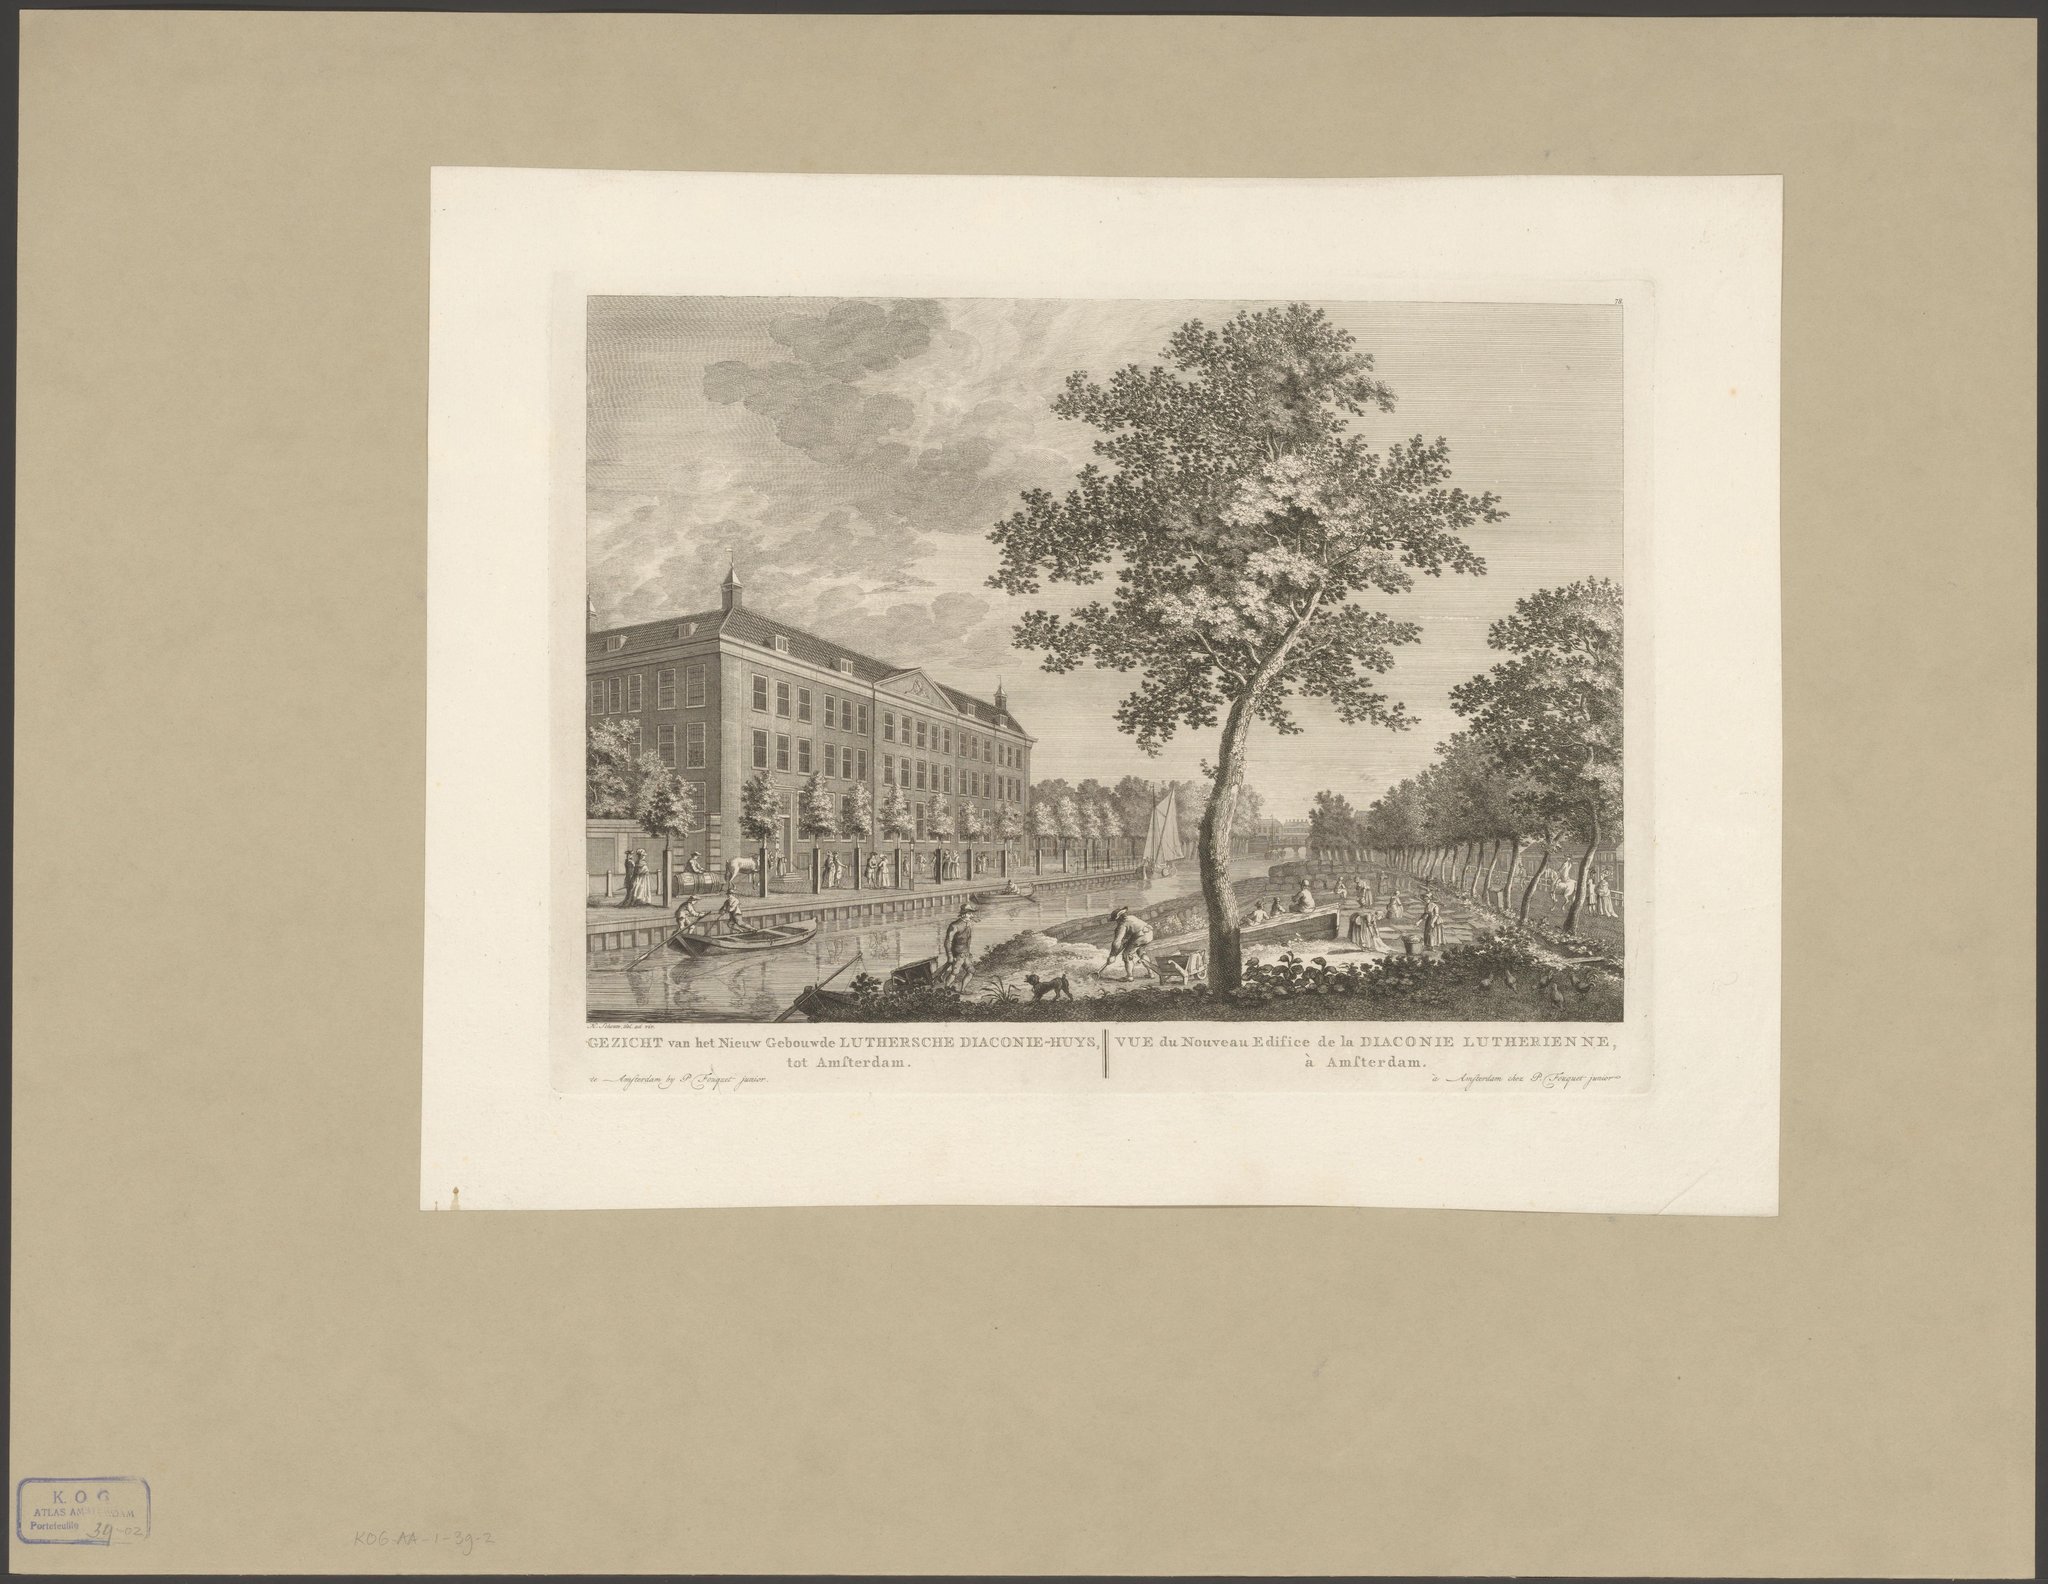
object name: print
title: Atlas van Fouquet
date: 1770-1783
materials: paper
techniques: engraving, etching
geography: amsterdam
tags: canals, waters (in city) (+ city(-scape) with figures, staffage), old-people's home, street (+ city(-scape) with figures, staffage)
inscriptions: collector's mark: Lugt 1641b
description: Vanaf 1760 gaf Pierre Fouquet stadsgezichten van Amsterdam naar tekeningen van verschillende kunstenaars uit. Deze prenten werden aanvankelijk los verkocht. Later werden ze samengebonden verkocht in verschillende volgordes en aantallen in: (1). Afbeeldingen van de wyd-vermaarde koopstad Amsterdam benevens des zelvs voornaamste gebouwen en gezigten alle naar het leeven getekend / Receuil des edifices les plus considerables et des plus belles vues, de la fameuse ville d'Amsterdam, dessinées d'après nature. Amsterdam: Pierre Fouquet, 1778-1783. Deze 'uitgave' bestond waarschijnlijk alleen uit een titelblad en inhoudsopgave van de tot dusver 100 uitgegeven prenten, die de koper zelf aan zijn of haar reeds verzamelde prenten kon toevoegen. De hoeveelheid en volgorde van prenten verzameld onder deze titel verschilt dus sterk. (2). Nieuwe atlas, van de voornaamste gebouwen en gezigten der stad Amsterdam, met derzelver beknopte beschryvingen. 2 dln. Amsterdam: Daniël Jean Changuion en Petrus den Hengst [in opdracht van Pierre Fouquet], 1783. Ook werden er door verschillende uitgevers tussen 1788 (Amsterdam: Petrus Conradi) en 1805 (Amsterdam: Evert Maaskamp) heruitgaven gepubliceerd.